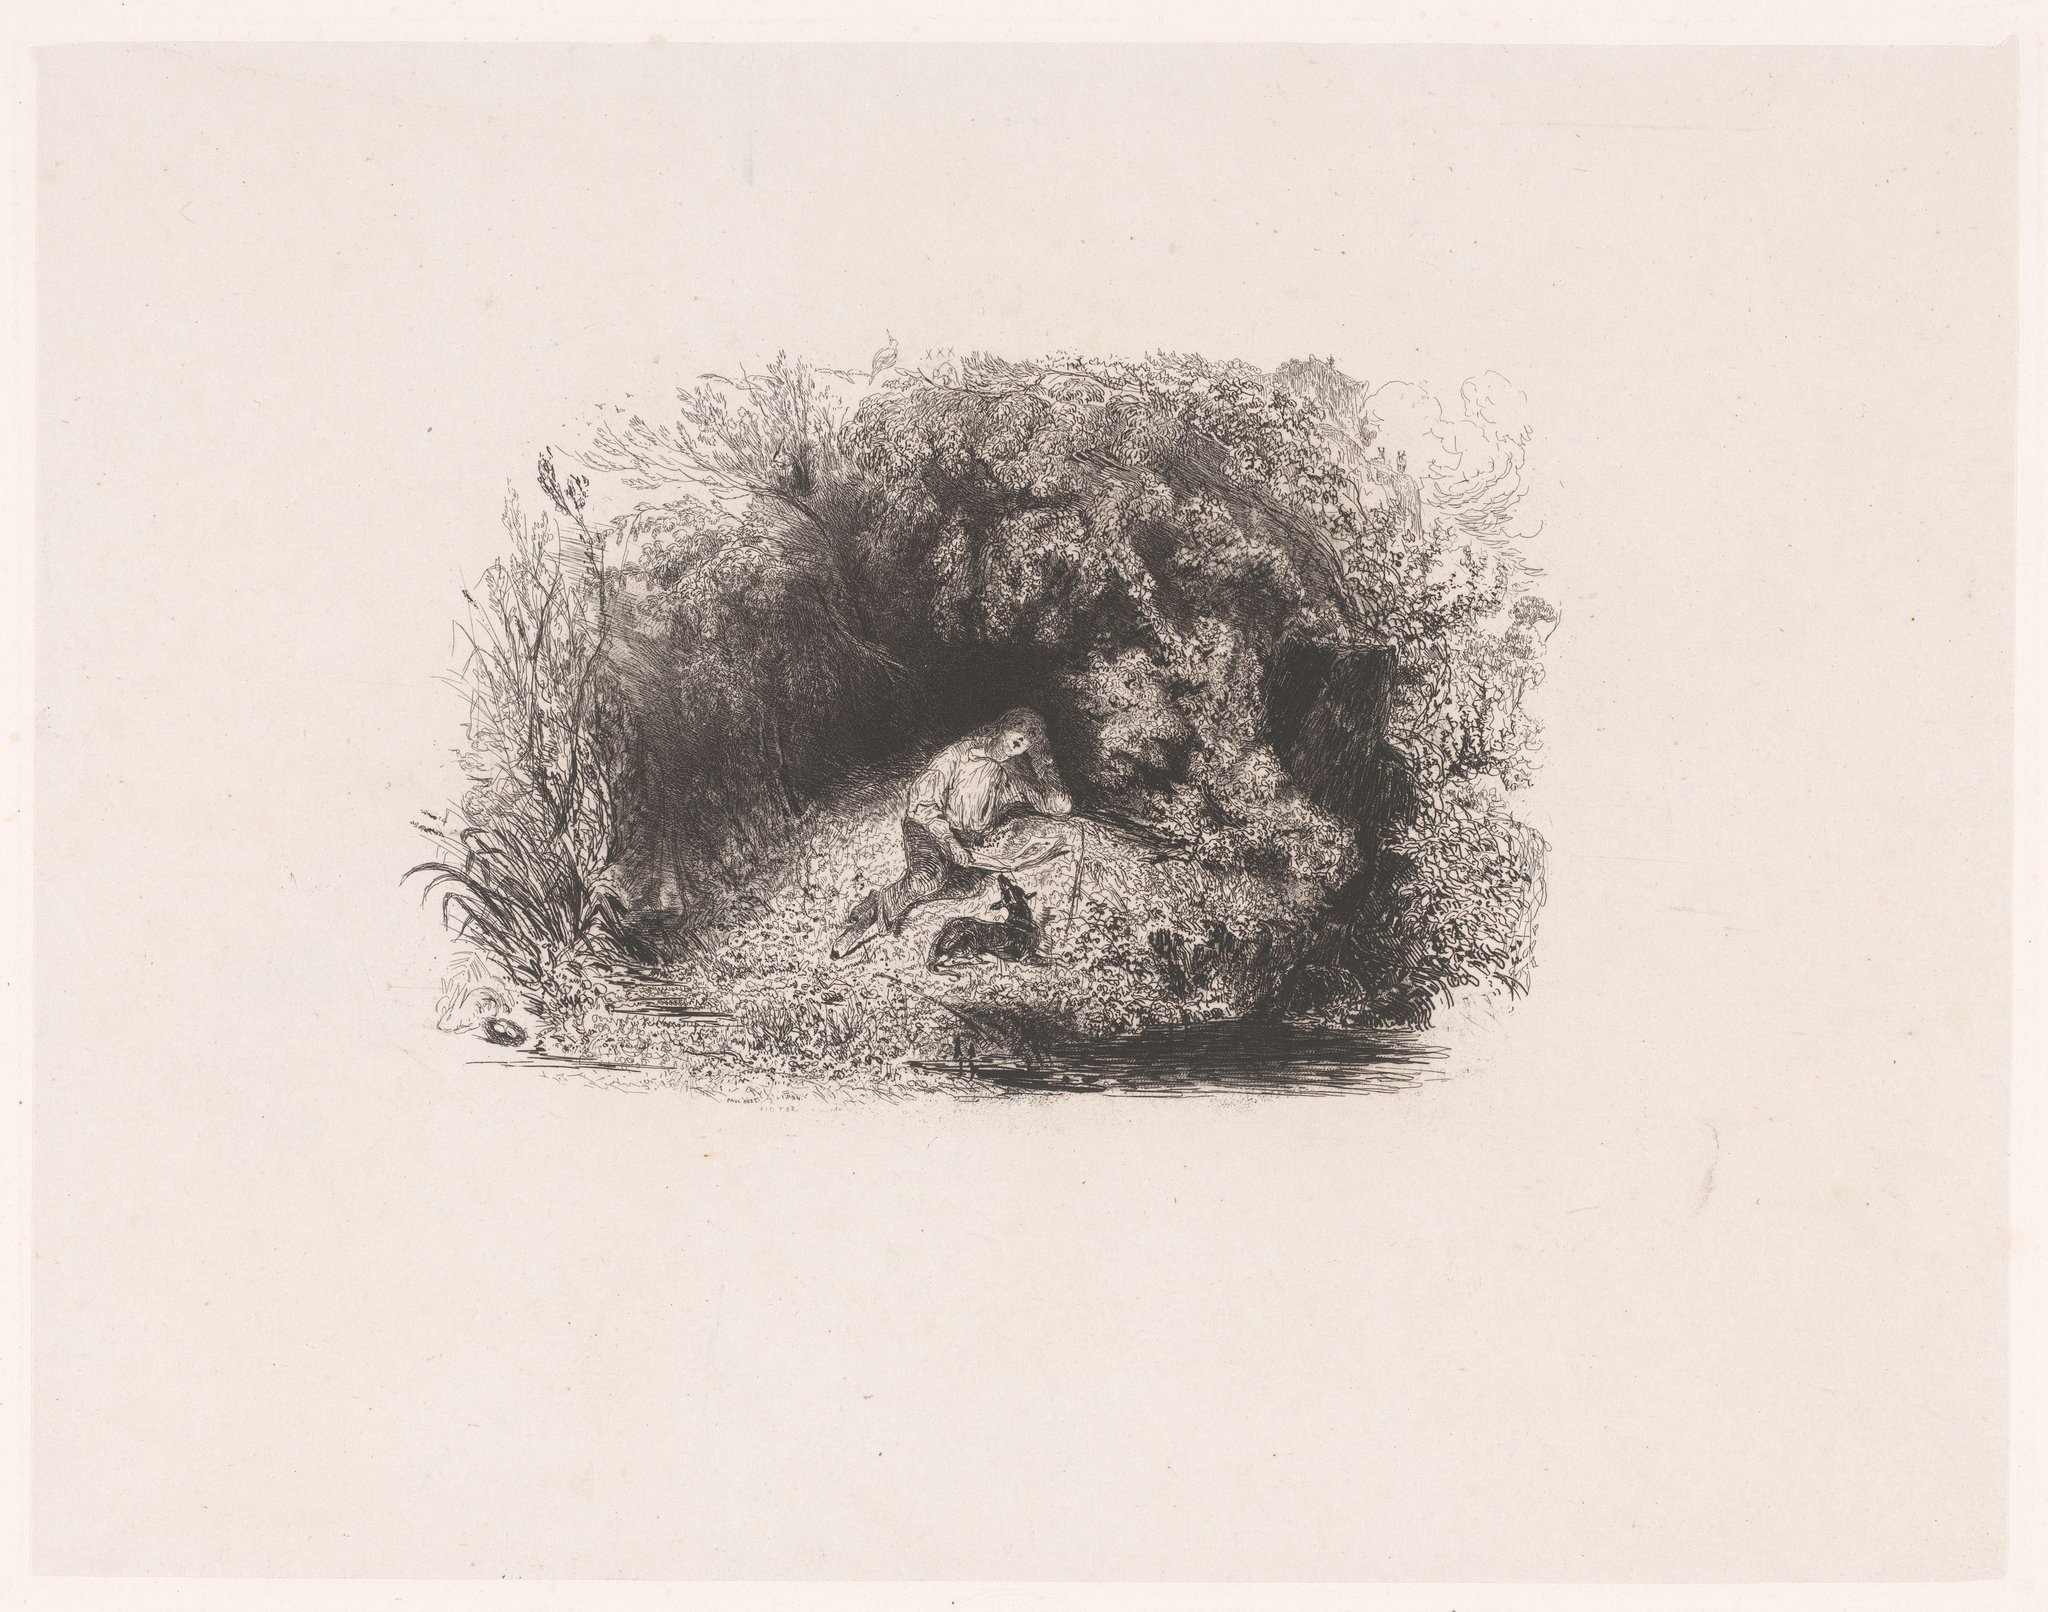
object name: print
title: Six Eaux-Fortes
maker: paul huet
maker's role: draughtsman, print maker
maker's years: 1803-1869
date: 1834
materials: paper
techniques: etching, roulette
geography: paris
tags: reading, forest, wood, resting - bb - out of doors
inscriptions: check stamp: Lugt 2140, collector's mark: Lugt 2228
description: Titelprent van een zesdelige serie met verschillende voorstellingen door Paul Huet.